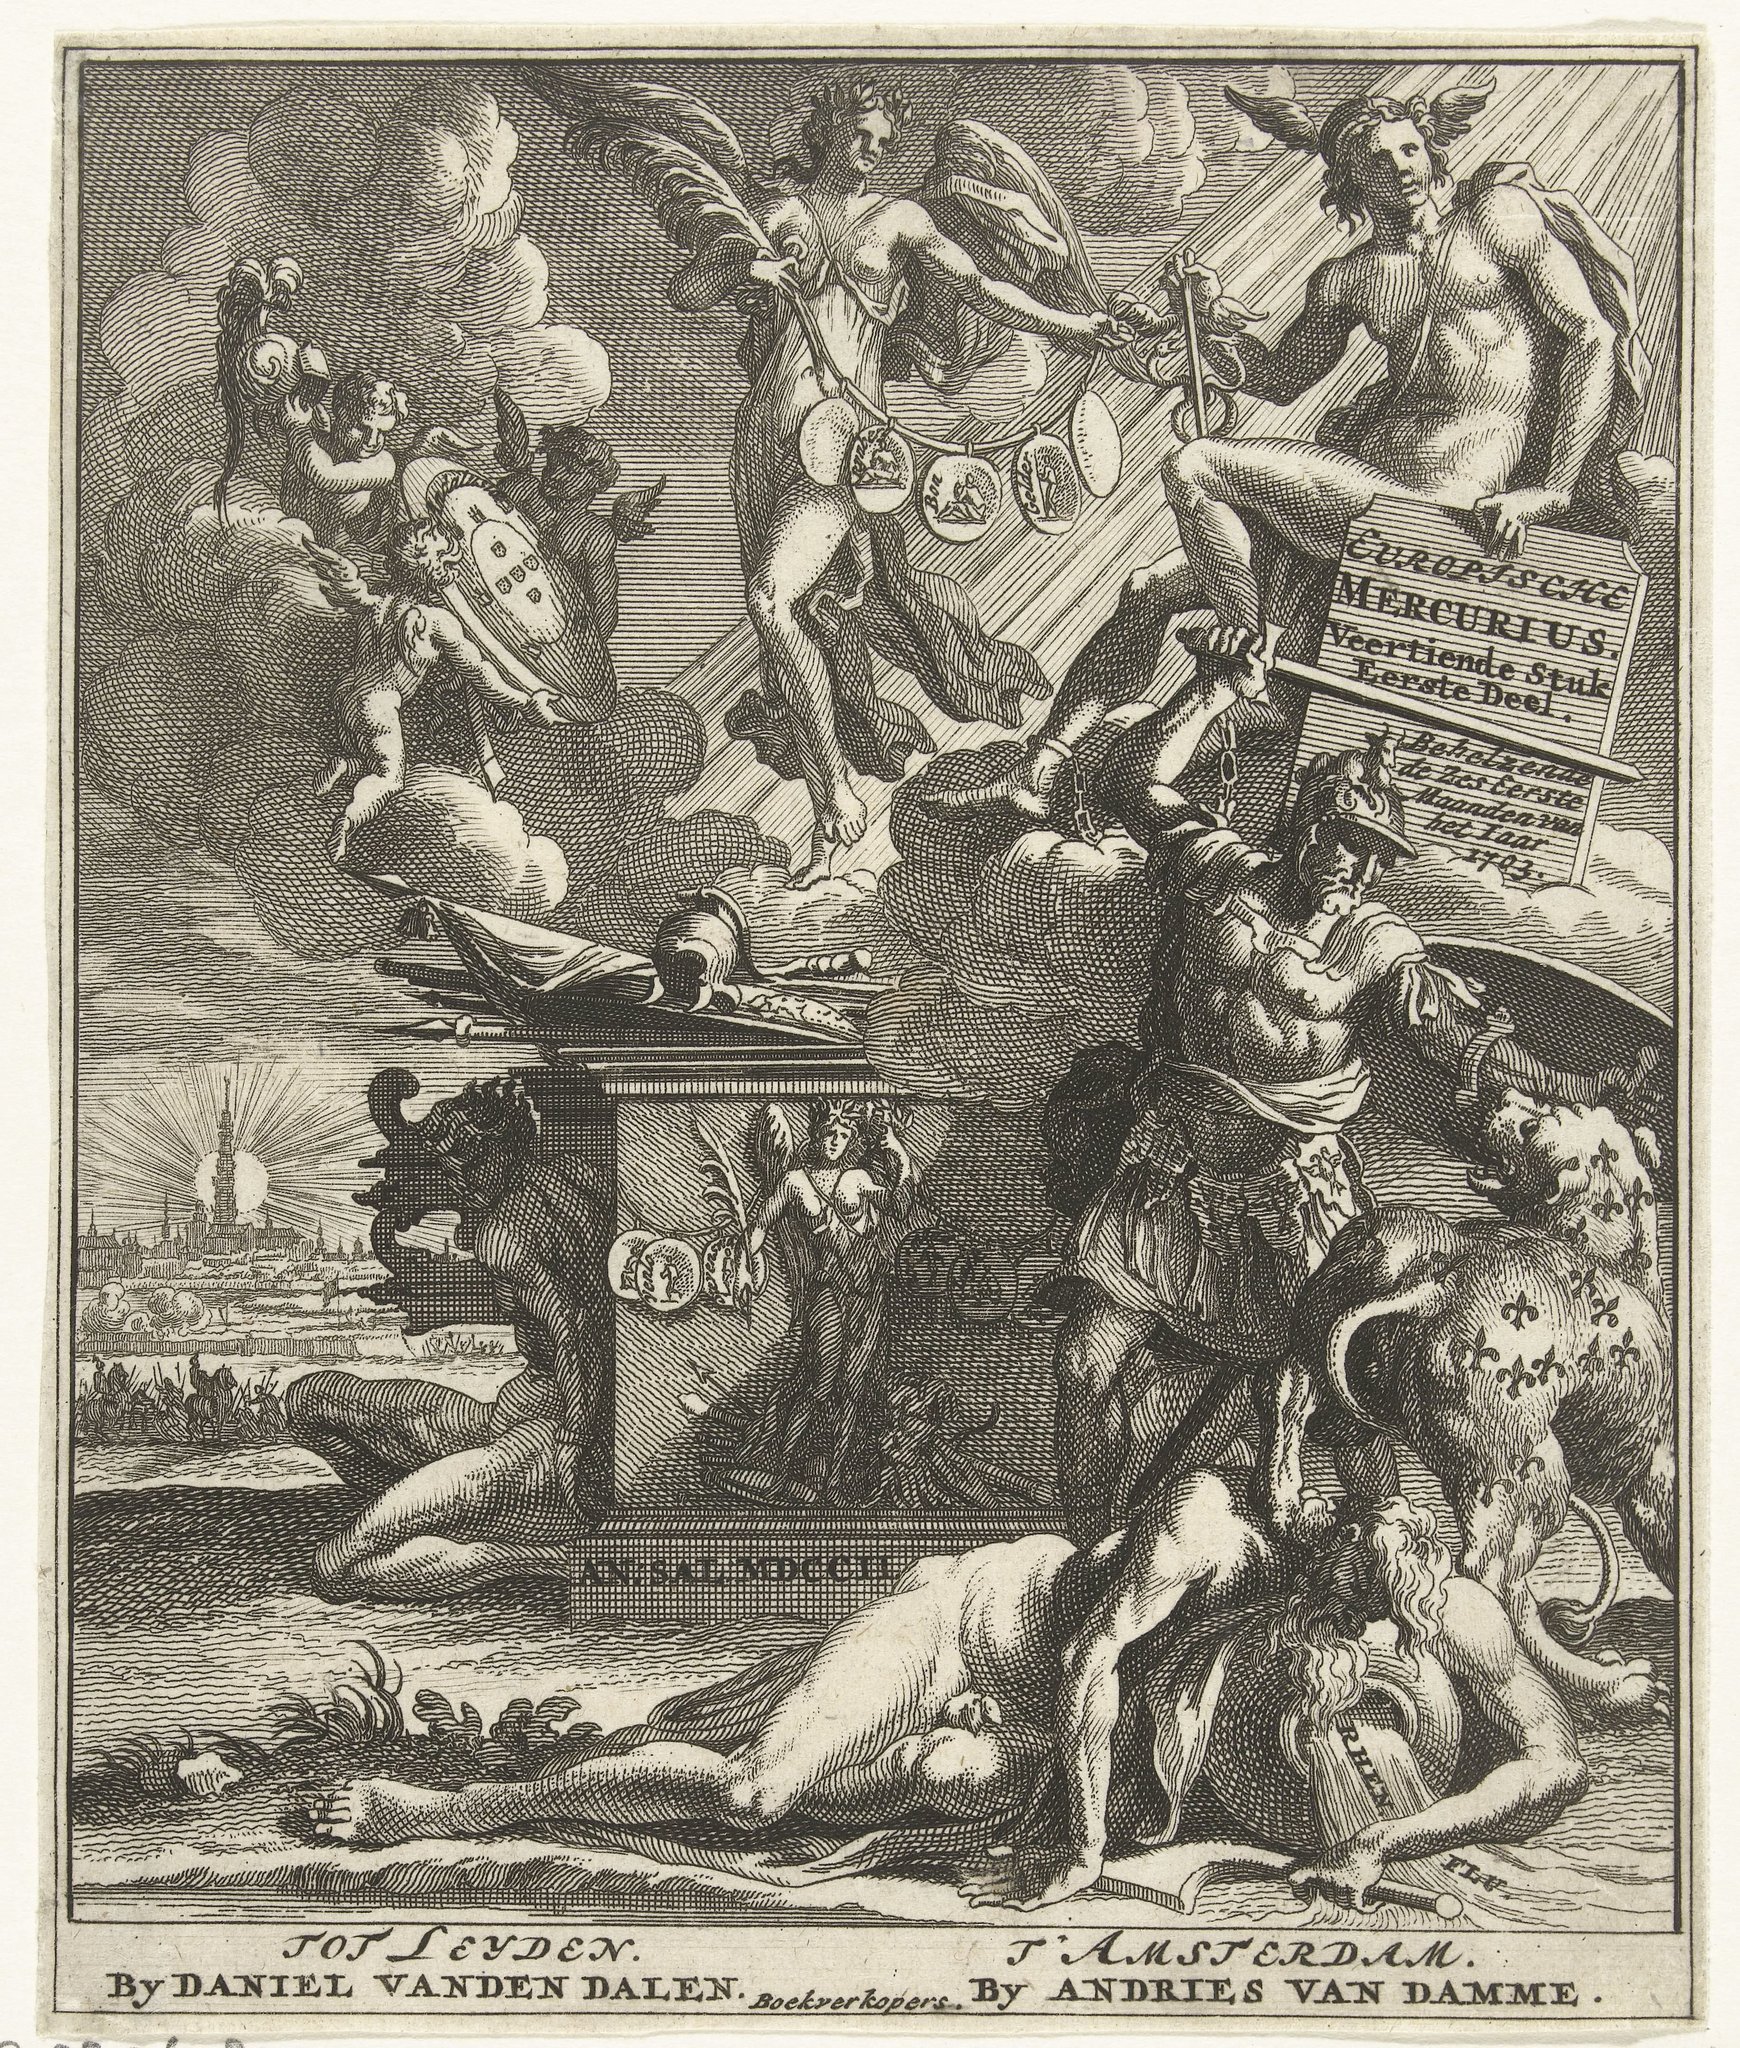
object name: titelblad, titelpagina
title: Titelpagina voor: Europische Mercurius Veertiende Stuk Eerste Deel, 1703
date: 1703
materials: paper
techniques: etching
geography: amsterdam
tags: specific aspects, allegorical aspects of mercury; mercury as patron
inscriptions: inscription: ‘EUROPISCHE/MERCURIUS/ ... / het Jaar/1703.’, signature: ‘TOT LEYDEN./By DANIEL VANDEN DALEN/Boekverkopers/T'AMSTERDAM/By ANDRIES VAN DAMME.’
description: Titelpagina voor: Europische Mercurius Veertiende Stuk Eerste Deel, behelzende de eerste 6 maanden van het jaar 1703. Altaar met het jaar 1702 en wapens waarboven een aan zijn voeten geketende Mercurius en de Overwinning. Rechts heft een krijger (het Duitse keizerrijk) het zwaard tegen een leeuw (Frankrijk). Op de voorgrond de riviergod van de Rijn.